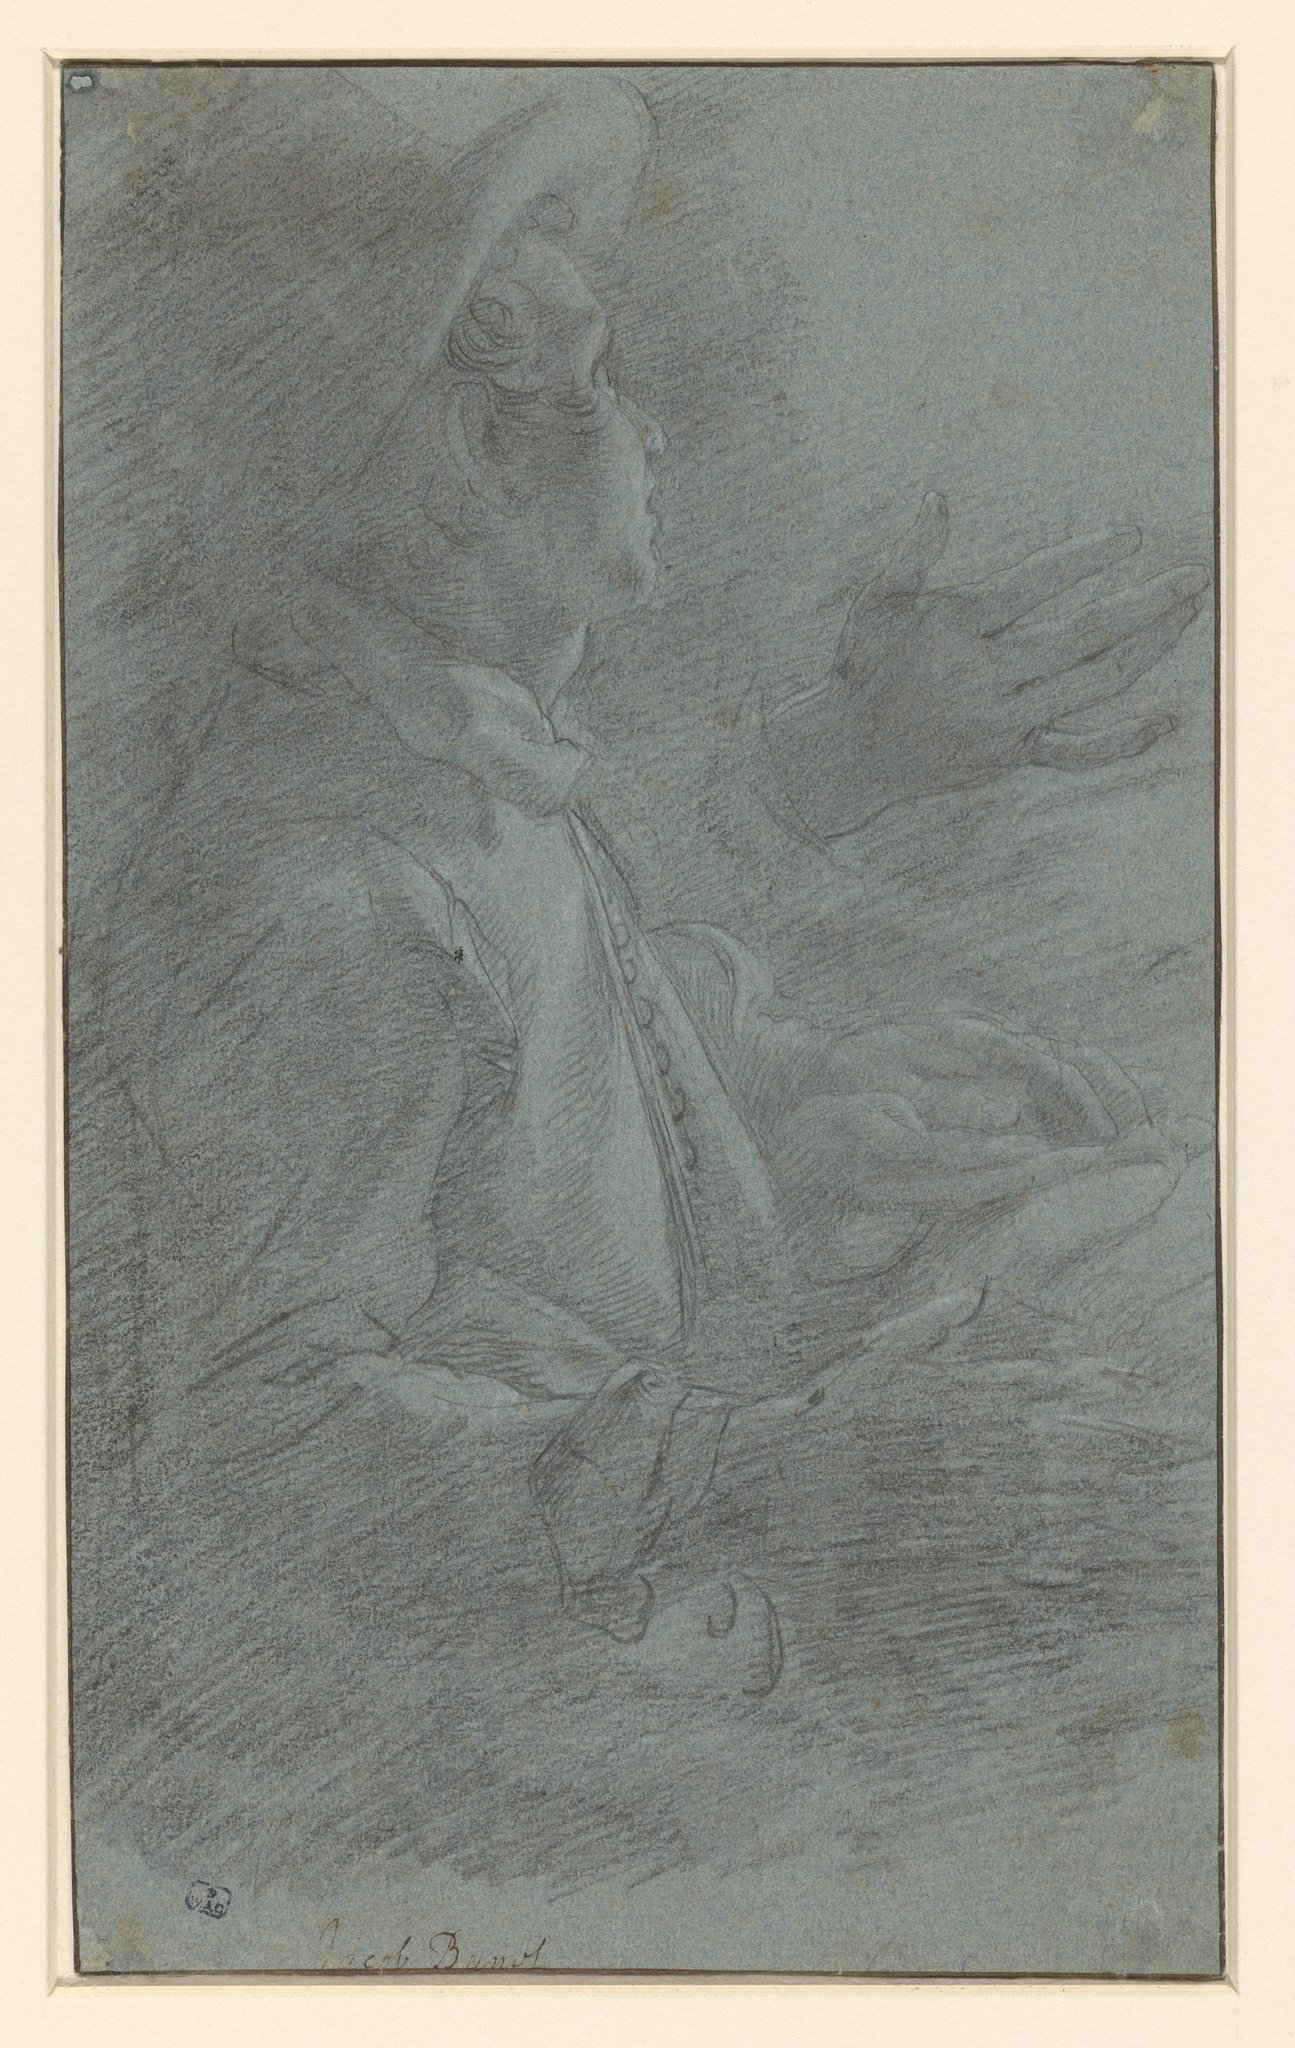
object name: drawing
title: Studie van een jongeman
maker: jacob bunel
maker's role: draughtsman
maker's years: 1558-1614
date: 1568-1614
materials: paper, pencil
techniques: brush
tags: youth, adolescent, postures and gestures of arms and hands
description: Studie van een jongeman met brede hoed op, naar rechts ziende, de rechterhand herhaald.